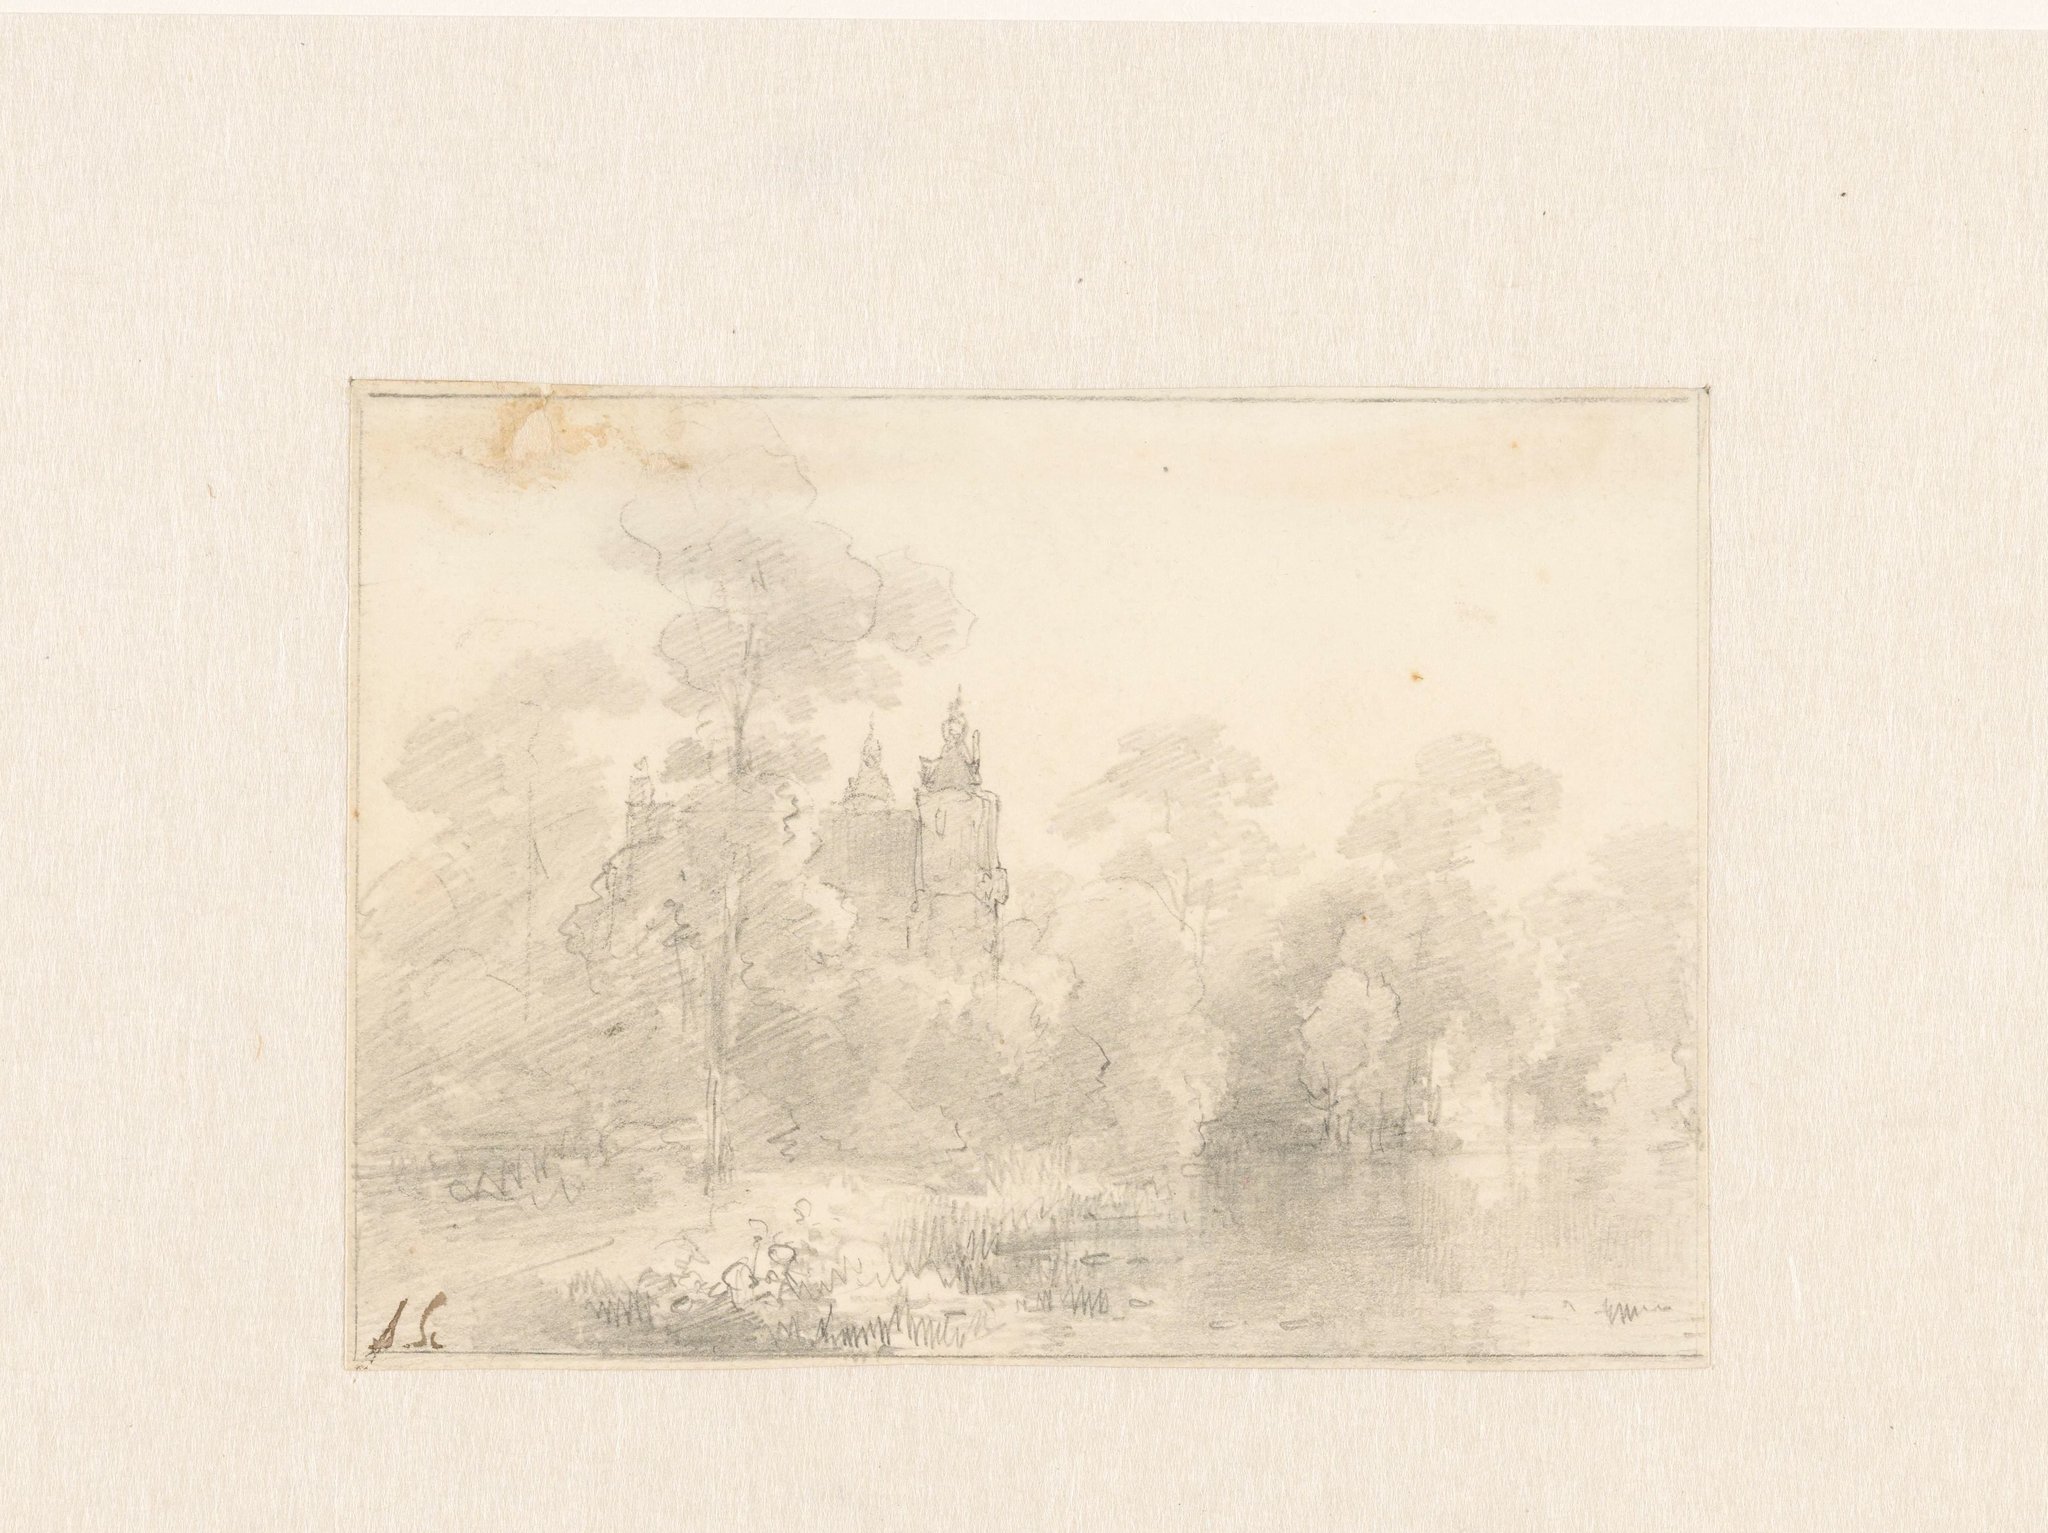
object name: drawing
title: Landschap met op de achtergrond een kasteel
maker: andreas schelfhout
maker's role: draughtsman, painter, print maker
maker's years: 1787-1870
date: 1797-1870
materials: paper, pencil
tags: landscapes, castle